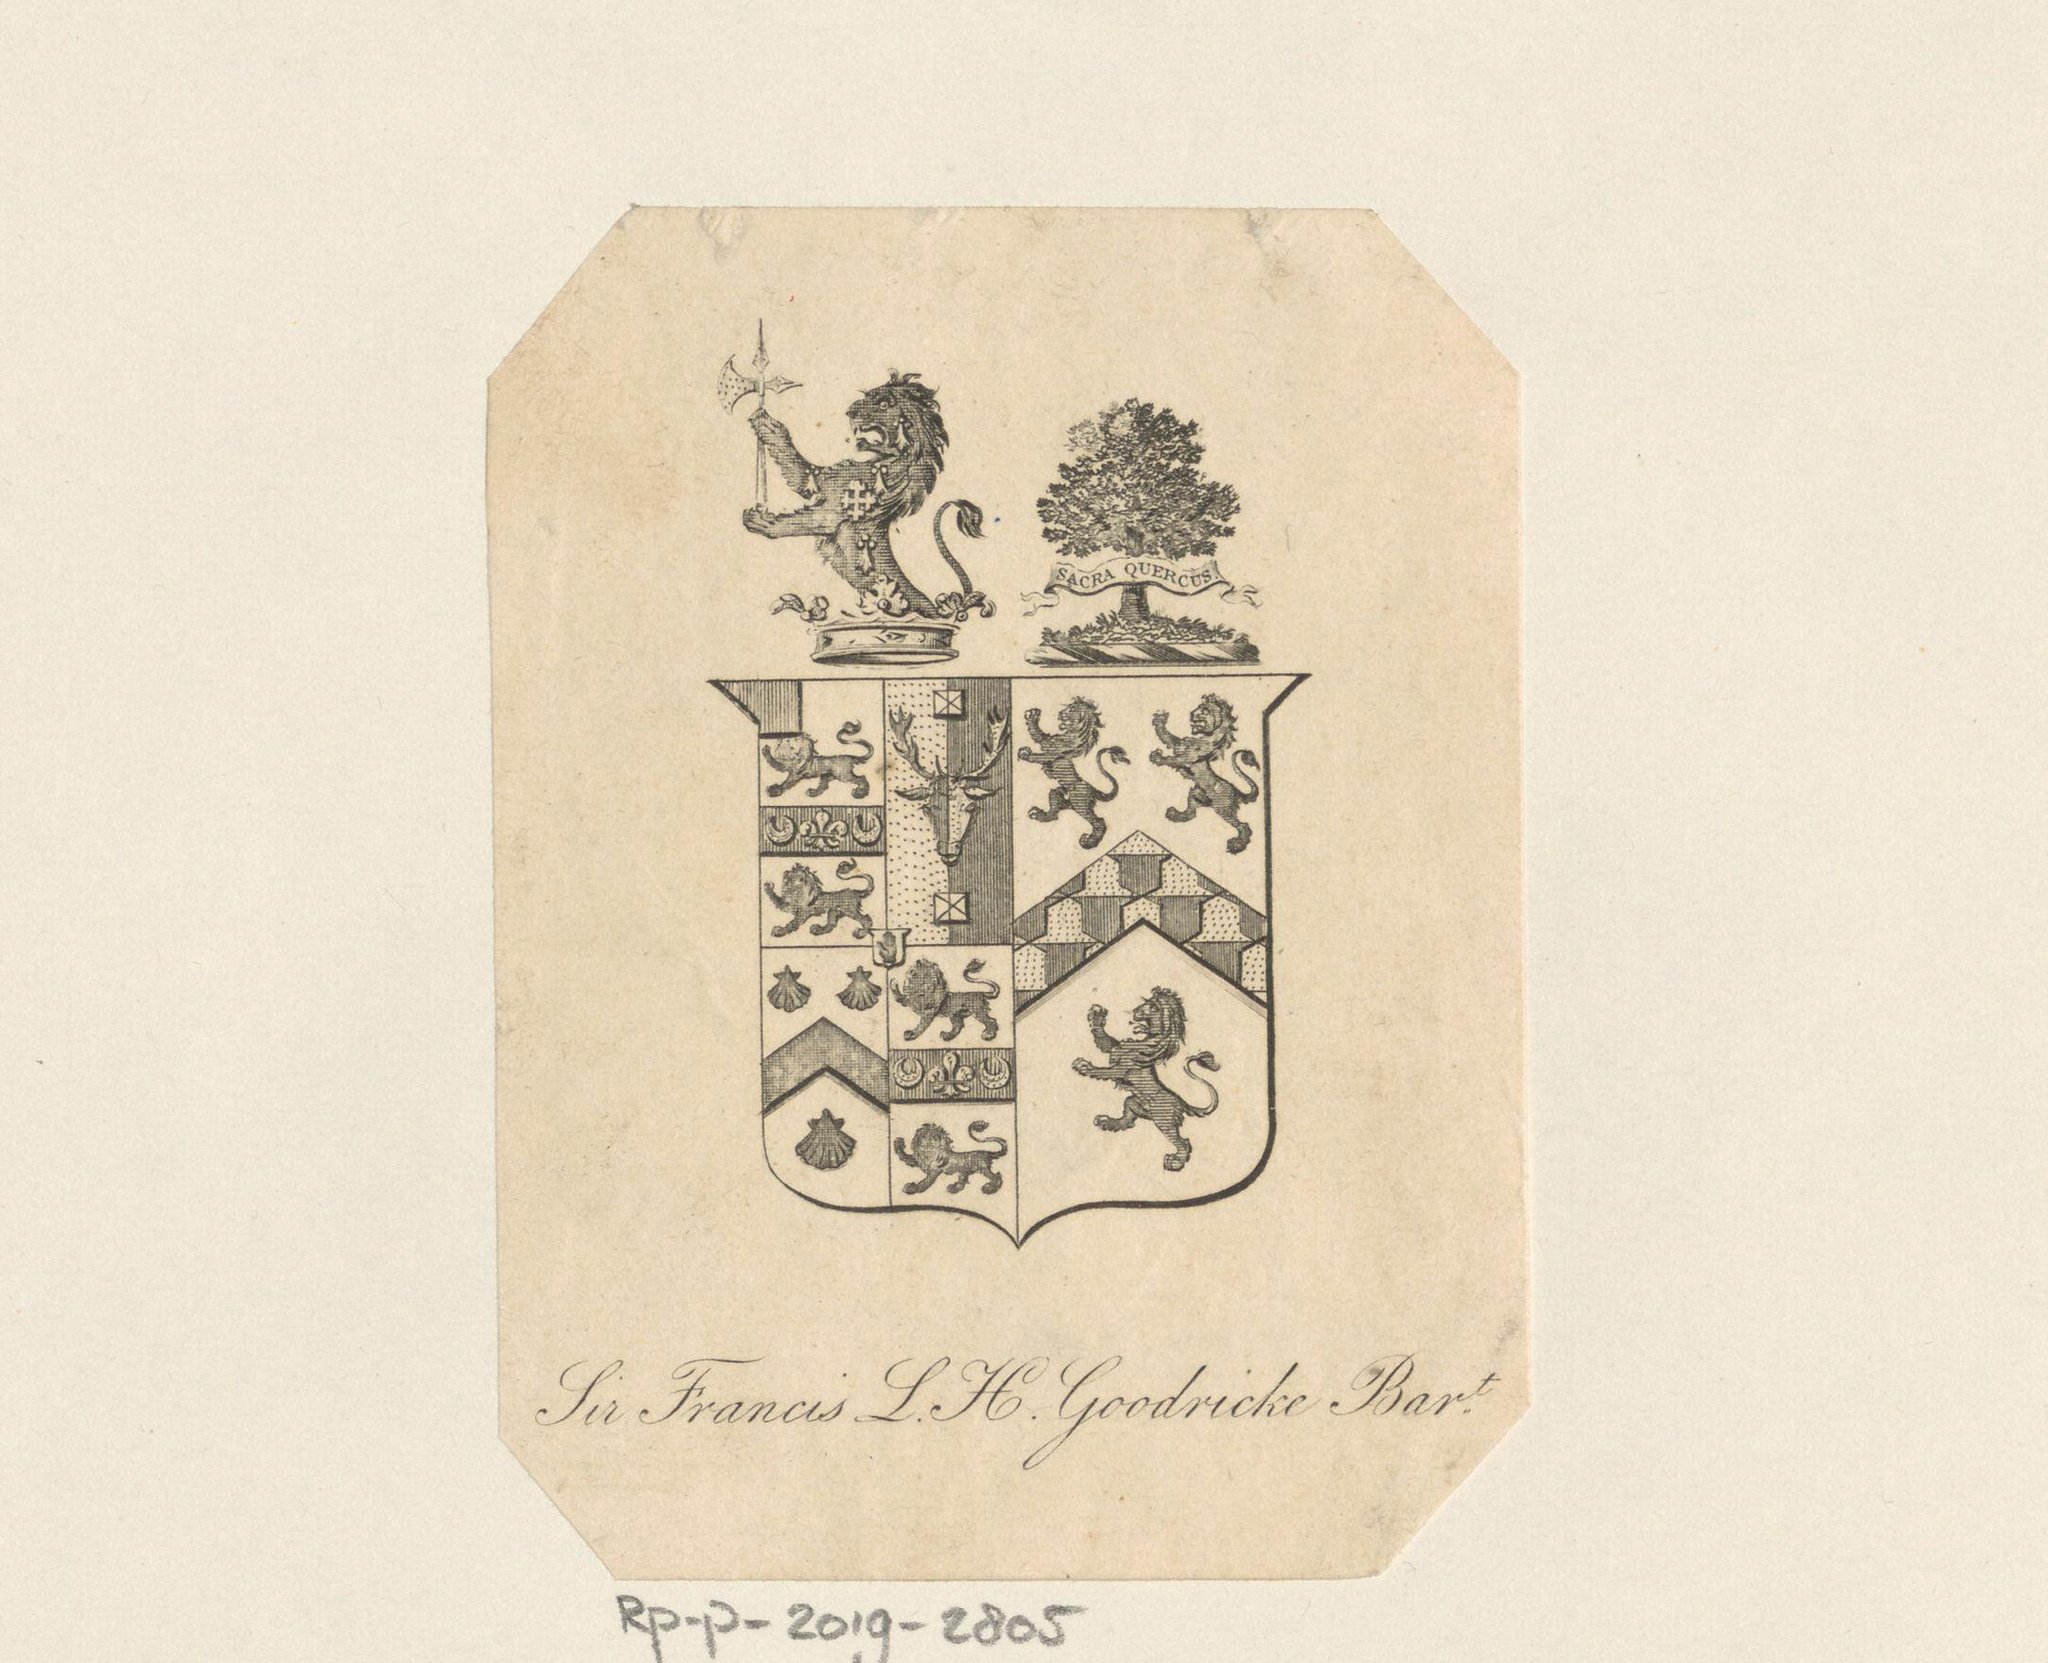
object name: bookplate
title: Ex libris van Sir Francis L.H. Goodricke Bart.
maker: Anonymous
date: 1800-1899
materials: paper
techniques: engraving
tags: armorial bearing, heraldry